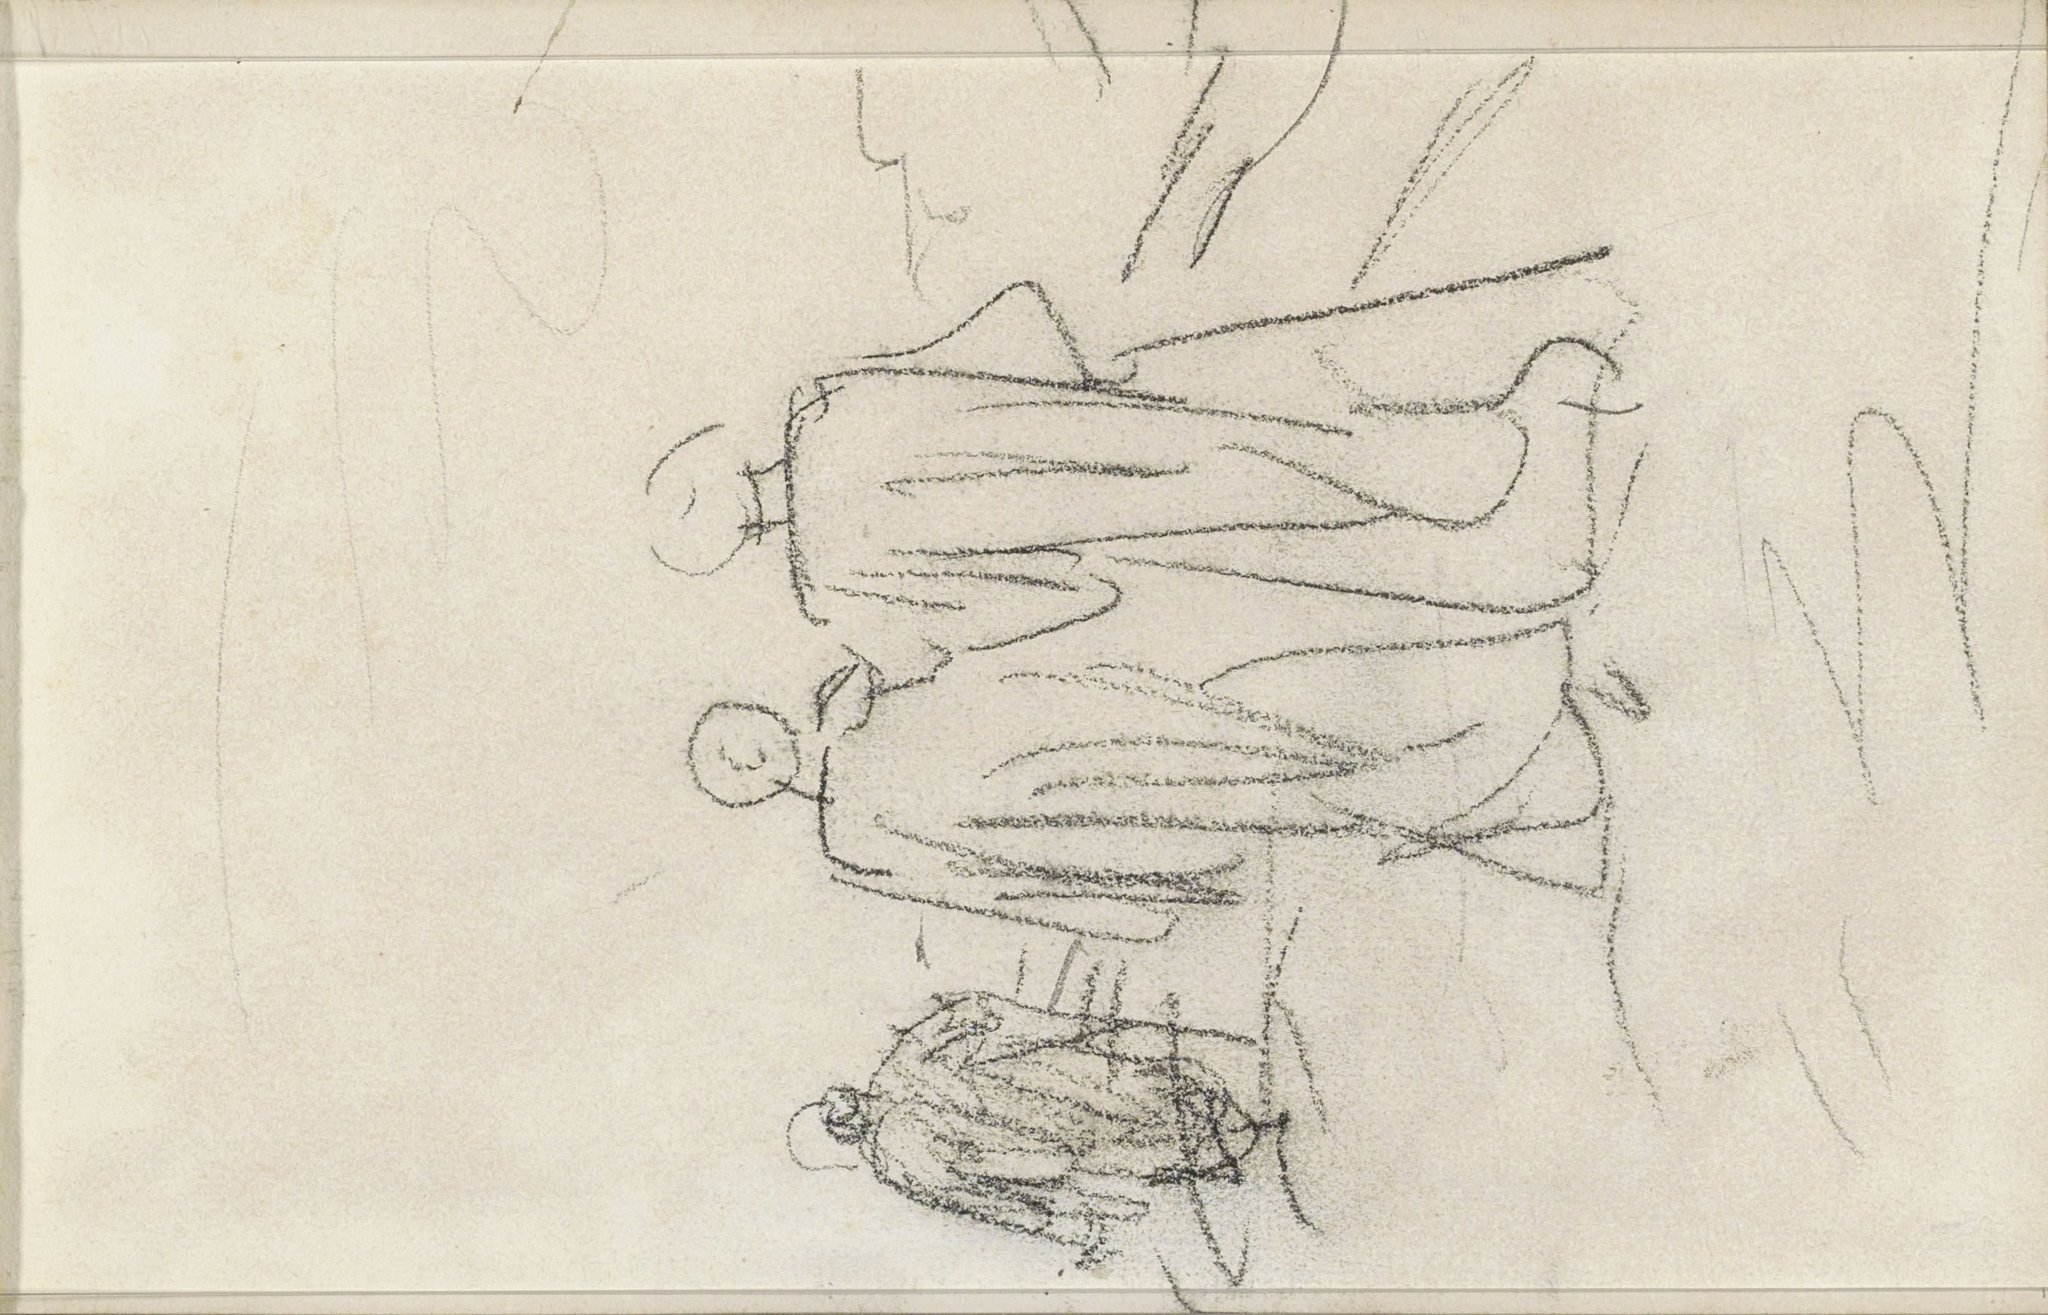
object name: sketchbook leaf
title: Drie Egyptenaren, op de rug gezien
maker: marius bauer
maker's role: draughtsman, print maker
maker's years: 1867-1932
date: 1919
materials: chalk, paper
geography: egypt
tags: africans, folk costume, regional costume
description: Pagina 1 uit een schetsboek met 18 bladen.